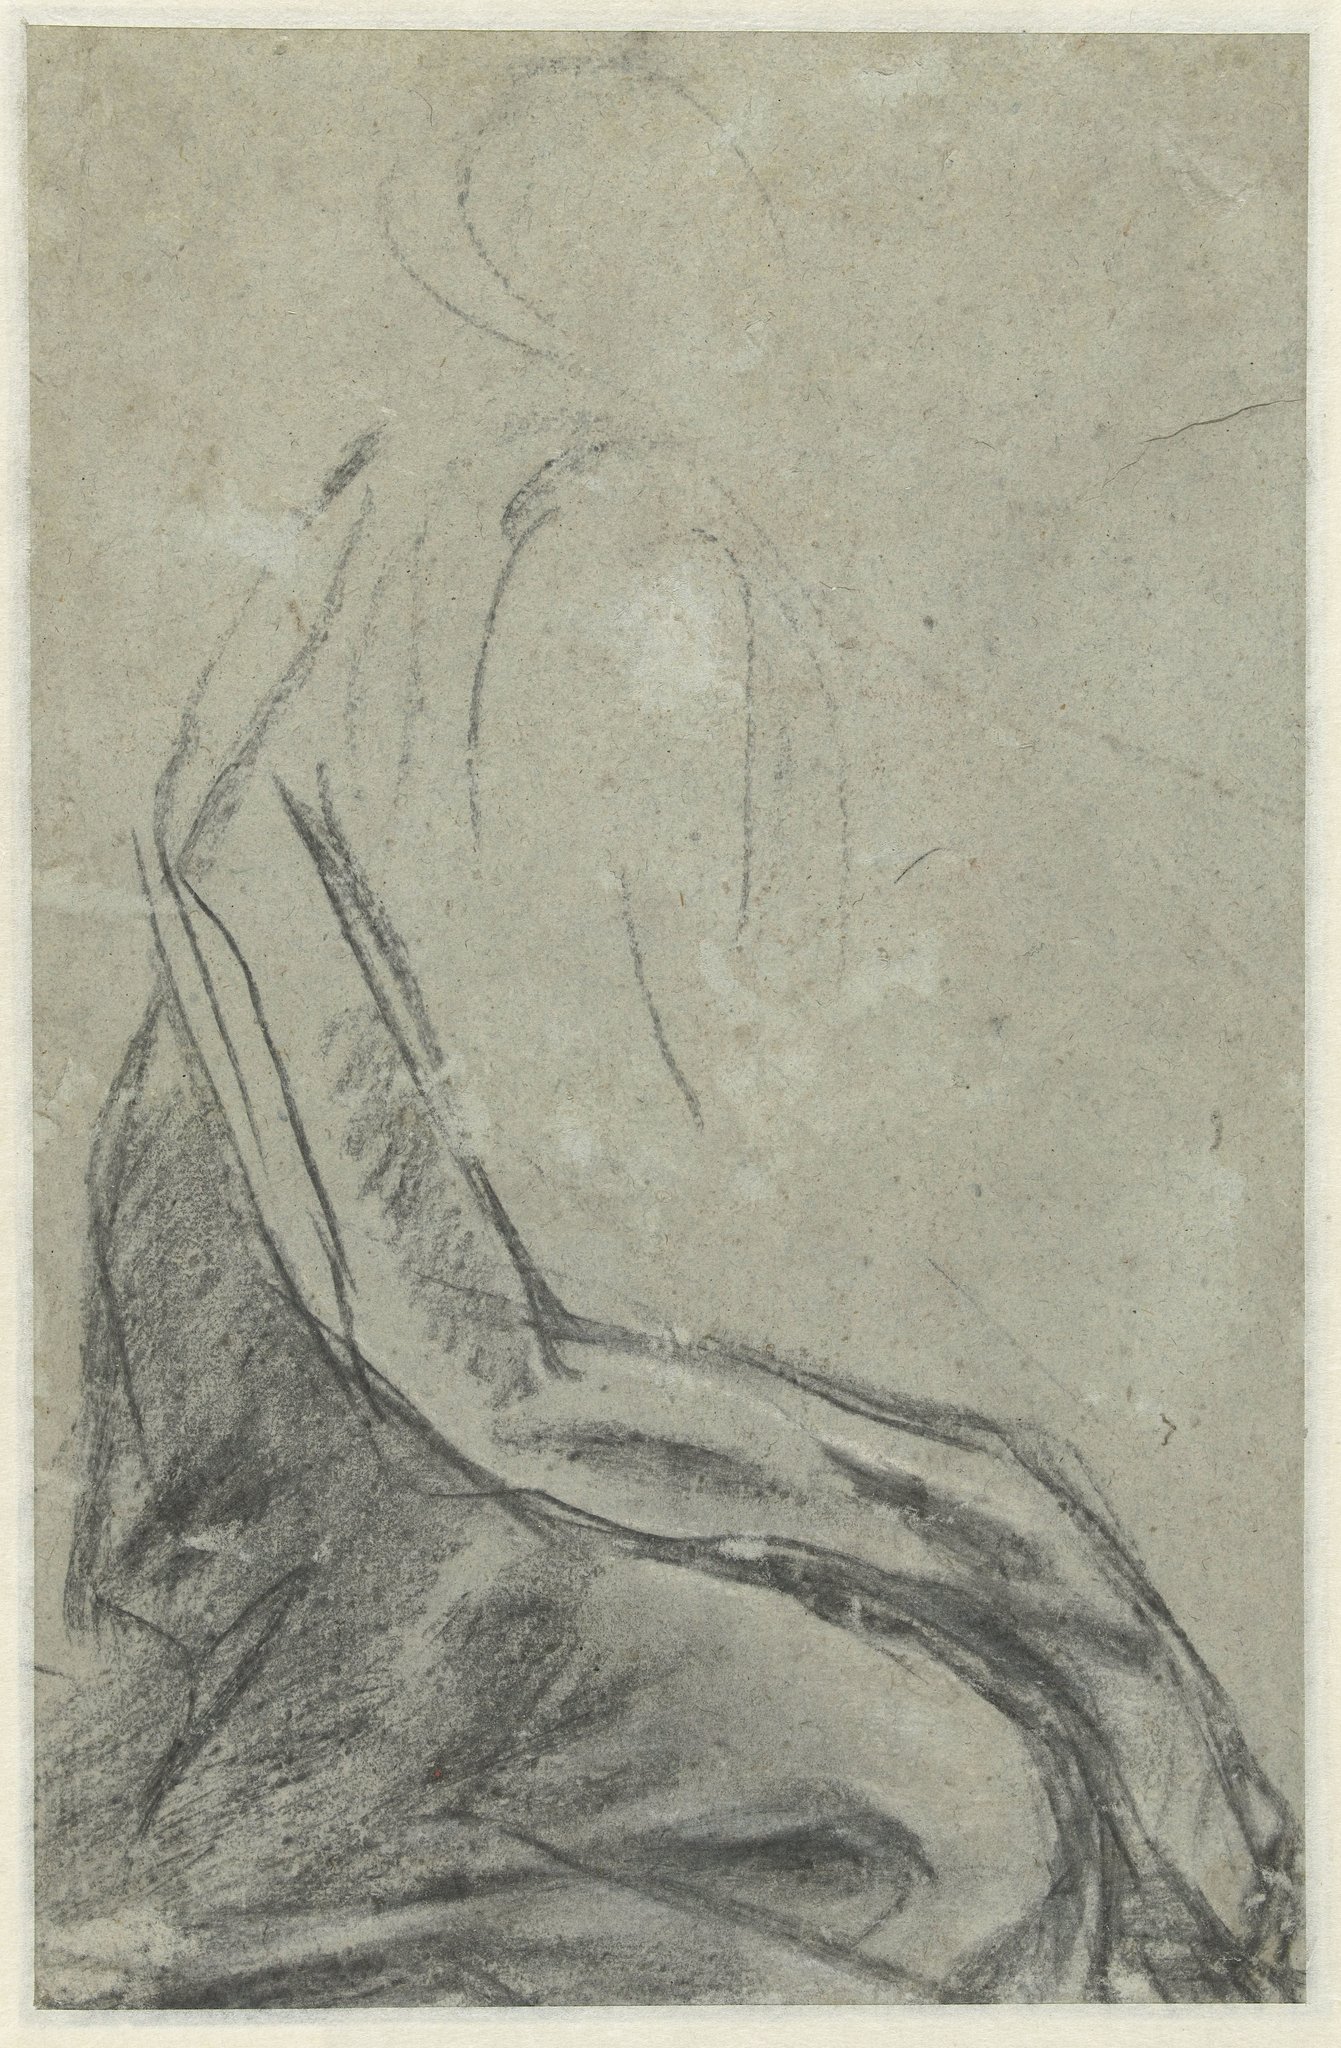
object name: drawing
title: Schets van een knielende figuur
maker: giacomo cavedone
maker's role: draughtsman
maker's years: 1577-1660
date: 1587-1660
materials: chalk, paper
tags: kneeling figure